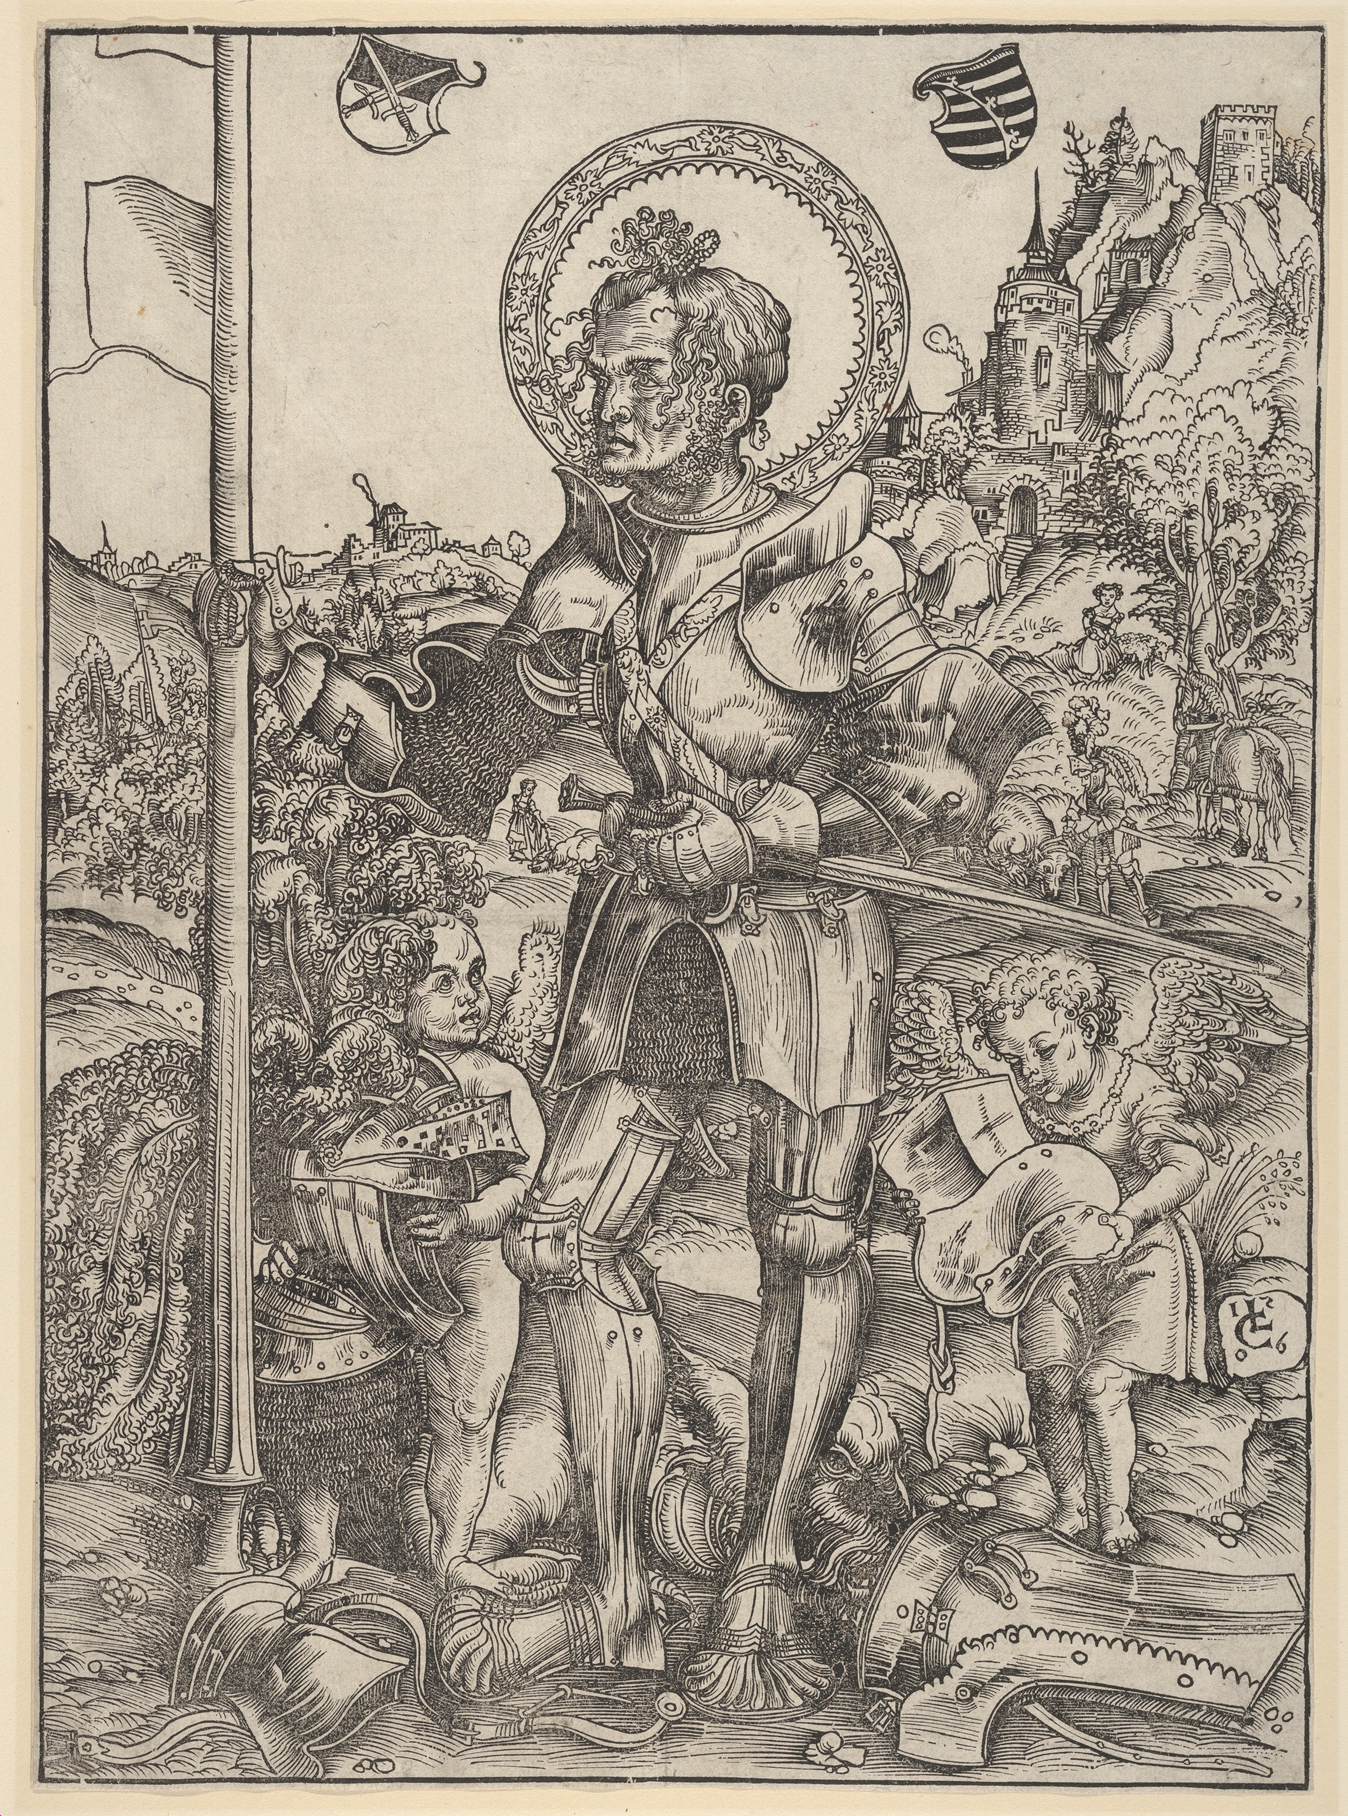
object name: print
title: Saint George Standing with Two Angels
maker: lucas cranach the elder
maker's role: artist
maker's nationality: german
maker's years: 1472-1553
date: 1506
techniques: woodcut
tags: angels,saint george